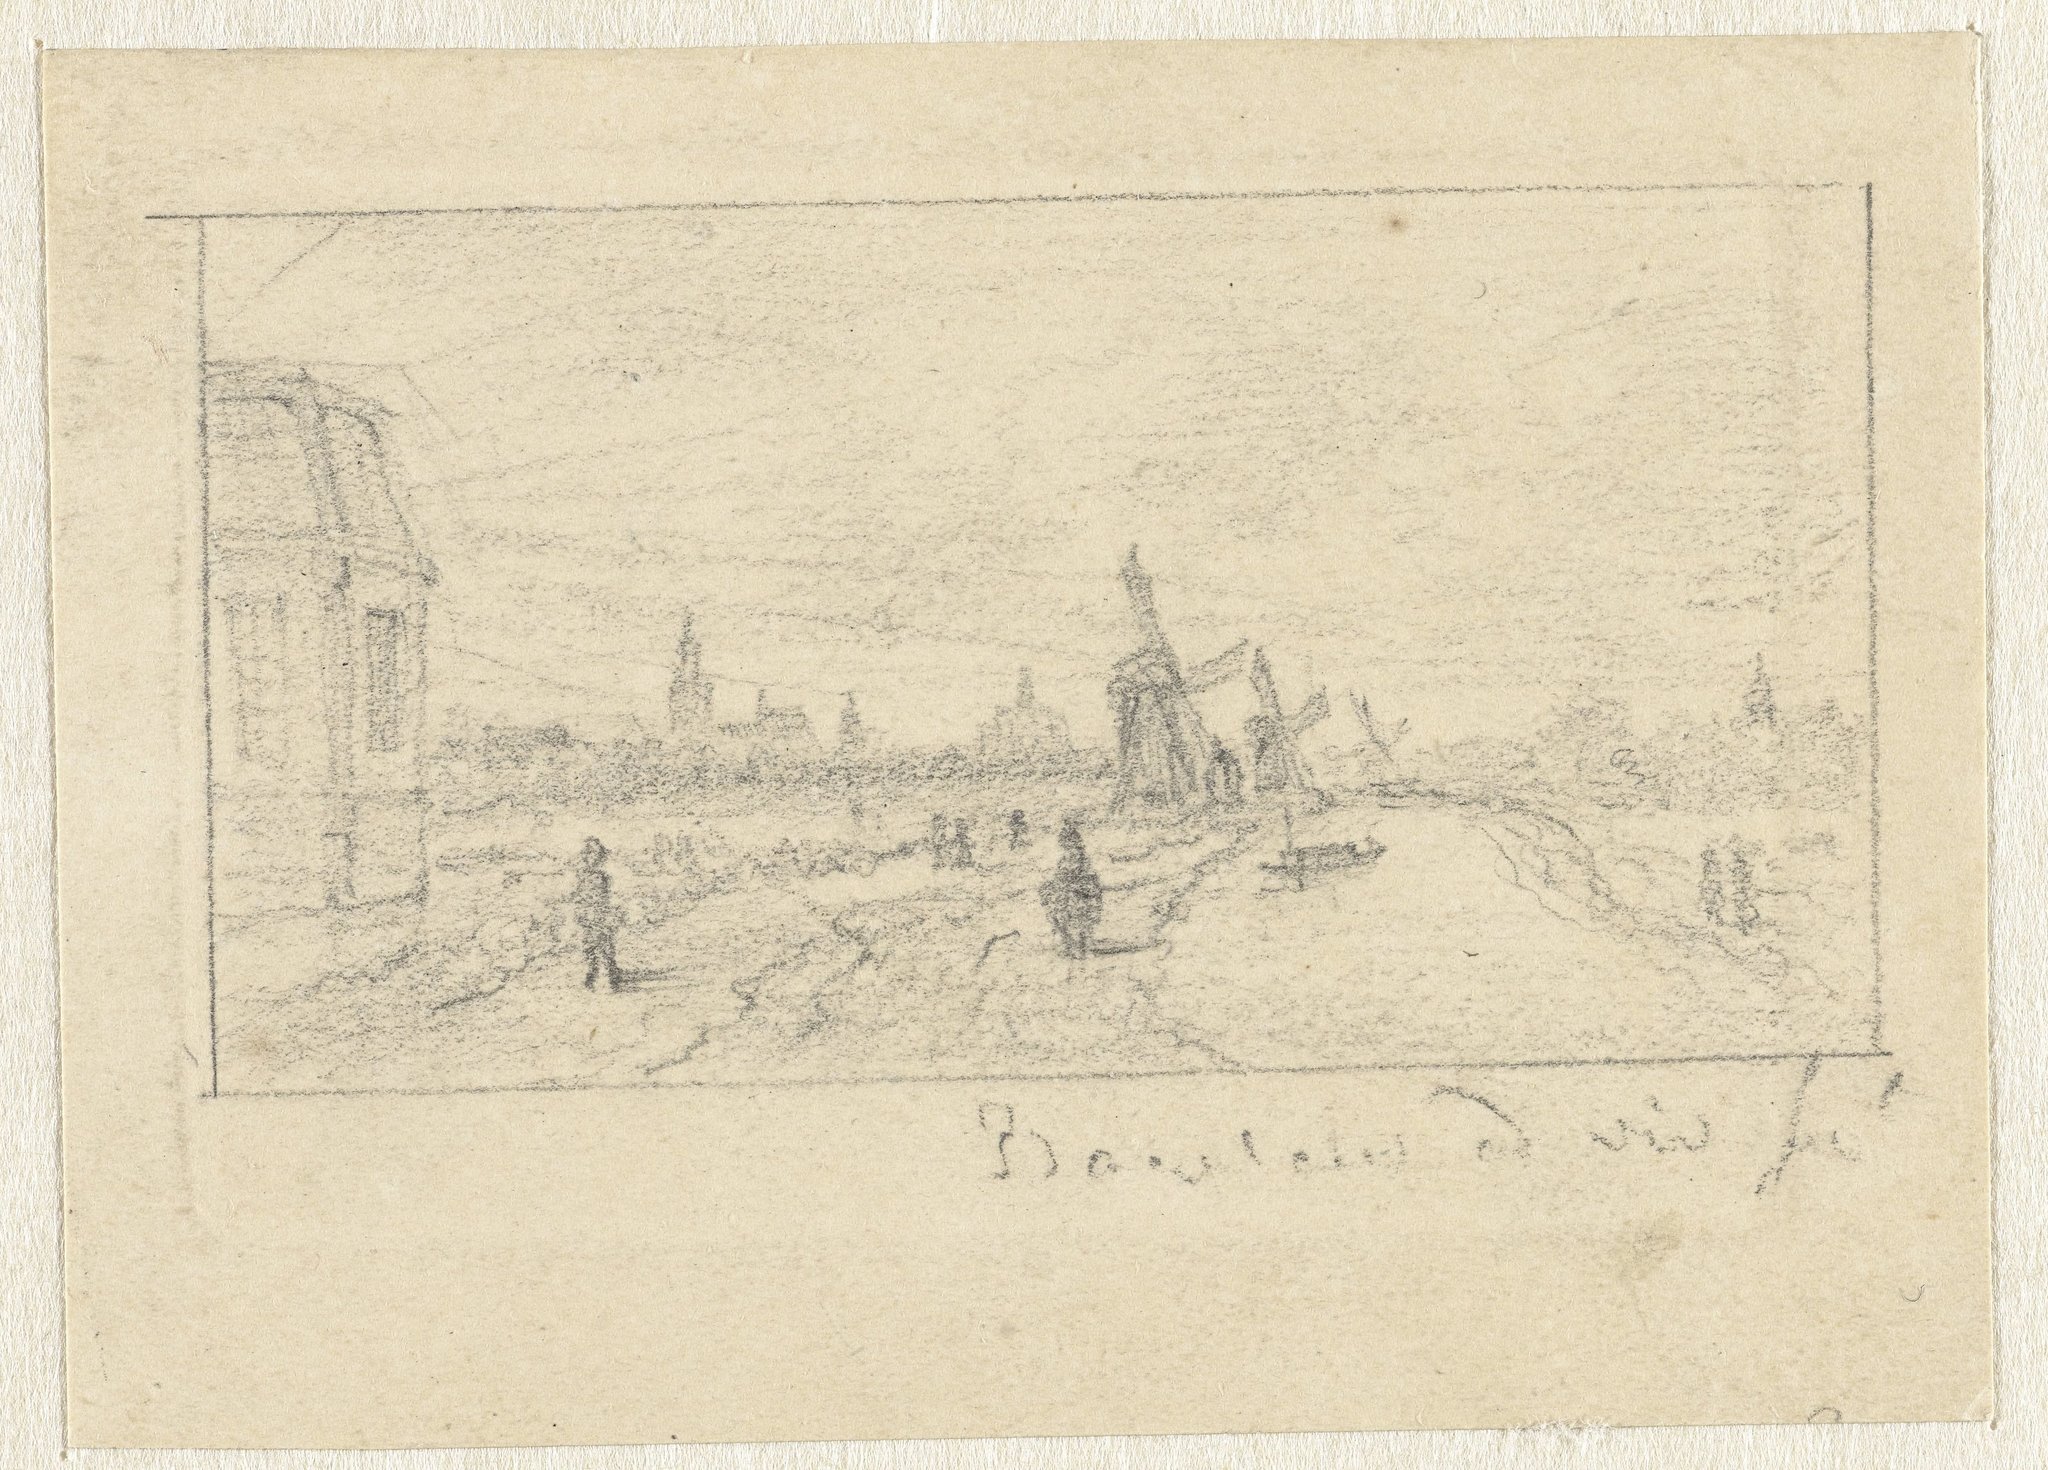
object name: design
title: Trekvaart en koepel van Caan aan de vaart van Den Haag naar Delft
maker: ernst willem jan bagelaar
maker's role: draughtsman, print maker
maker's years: 1775-1837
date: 1785-1837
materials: paper, pencil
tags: canal, the hague, delft